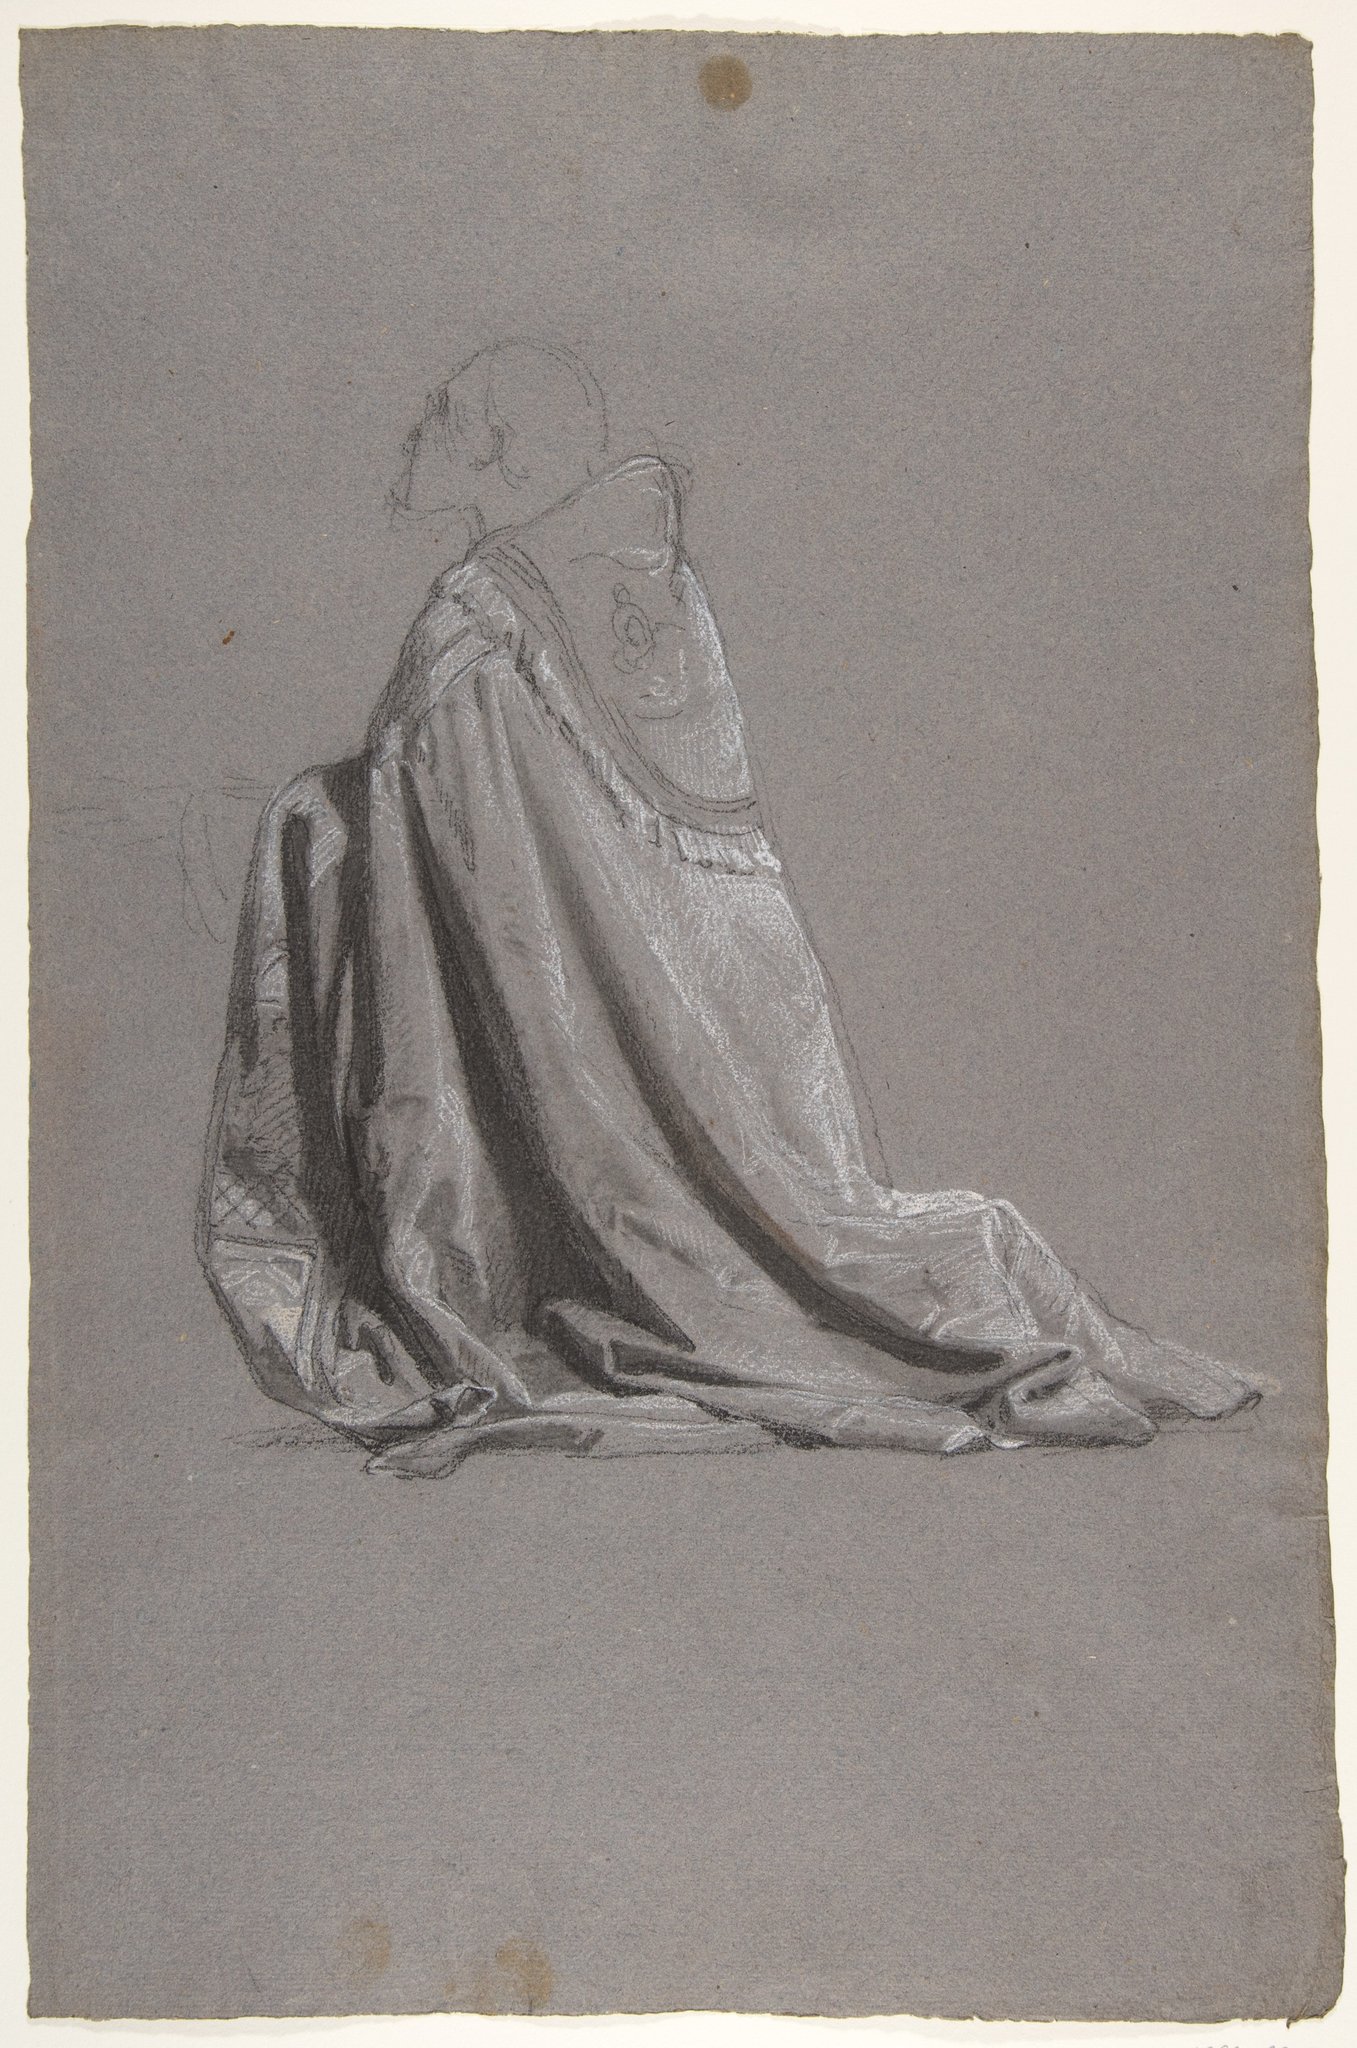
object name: drawing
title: Bishop (lower register; study for wall paintings in the Chapel of Saint Remi, Sainte-Clotilde, Paris, 1858)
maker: isidore pils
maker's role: artist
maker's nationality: french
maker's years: 1813-1875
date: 1801-1900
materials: chalk, paper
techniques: stumping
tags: bishops